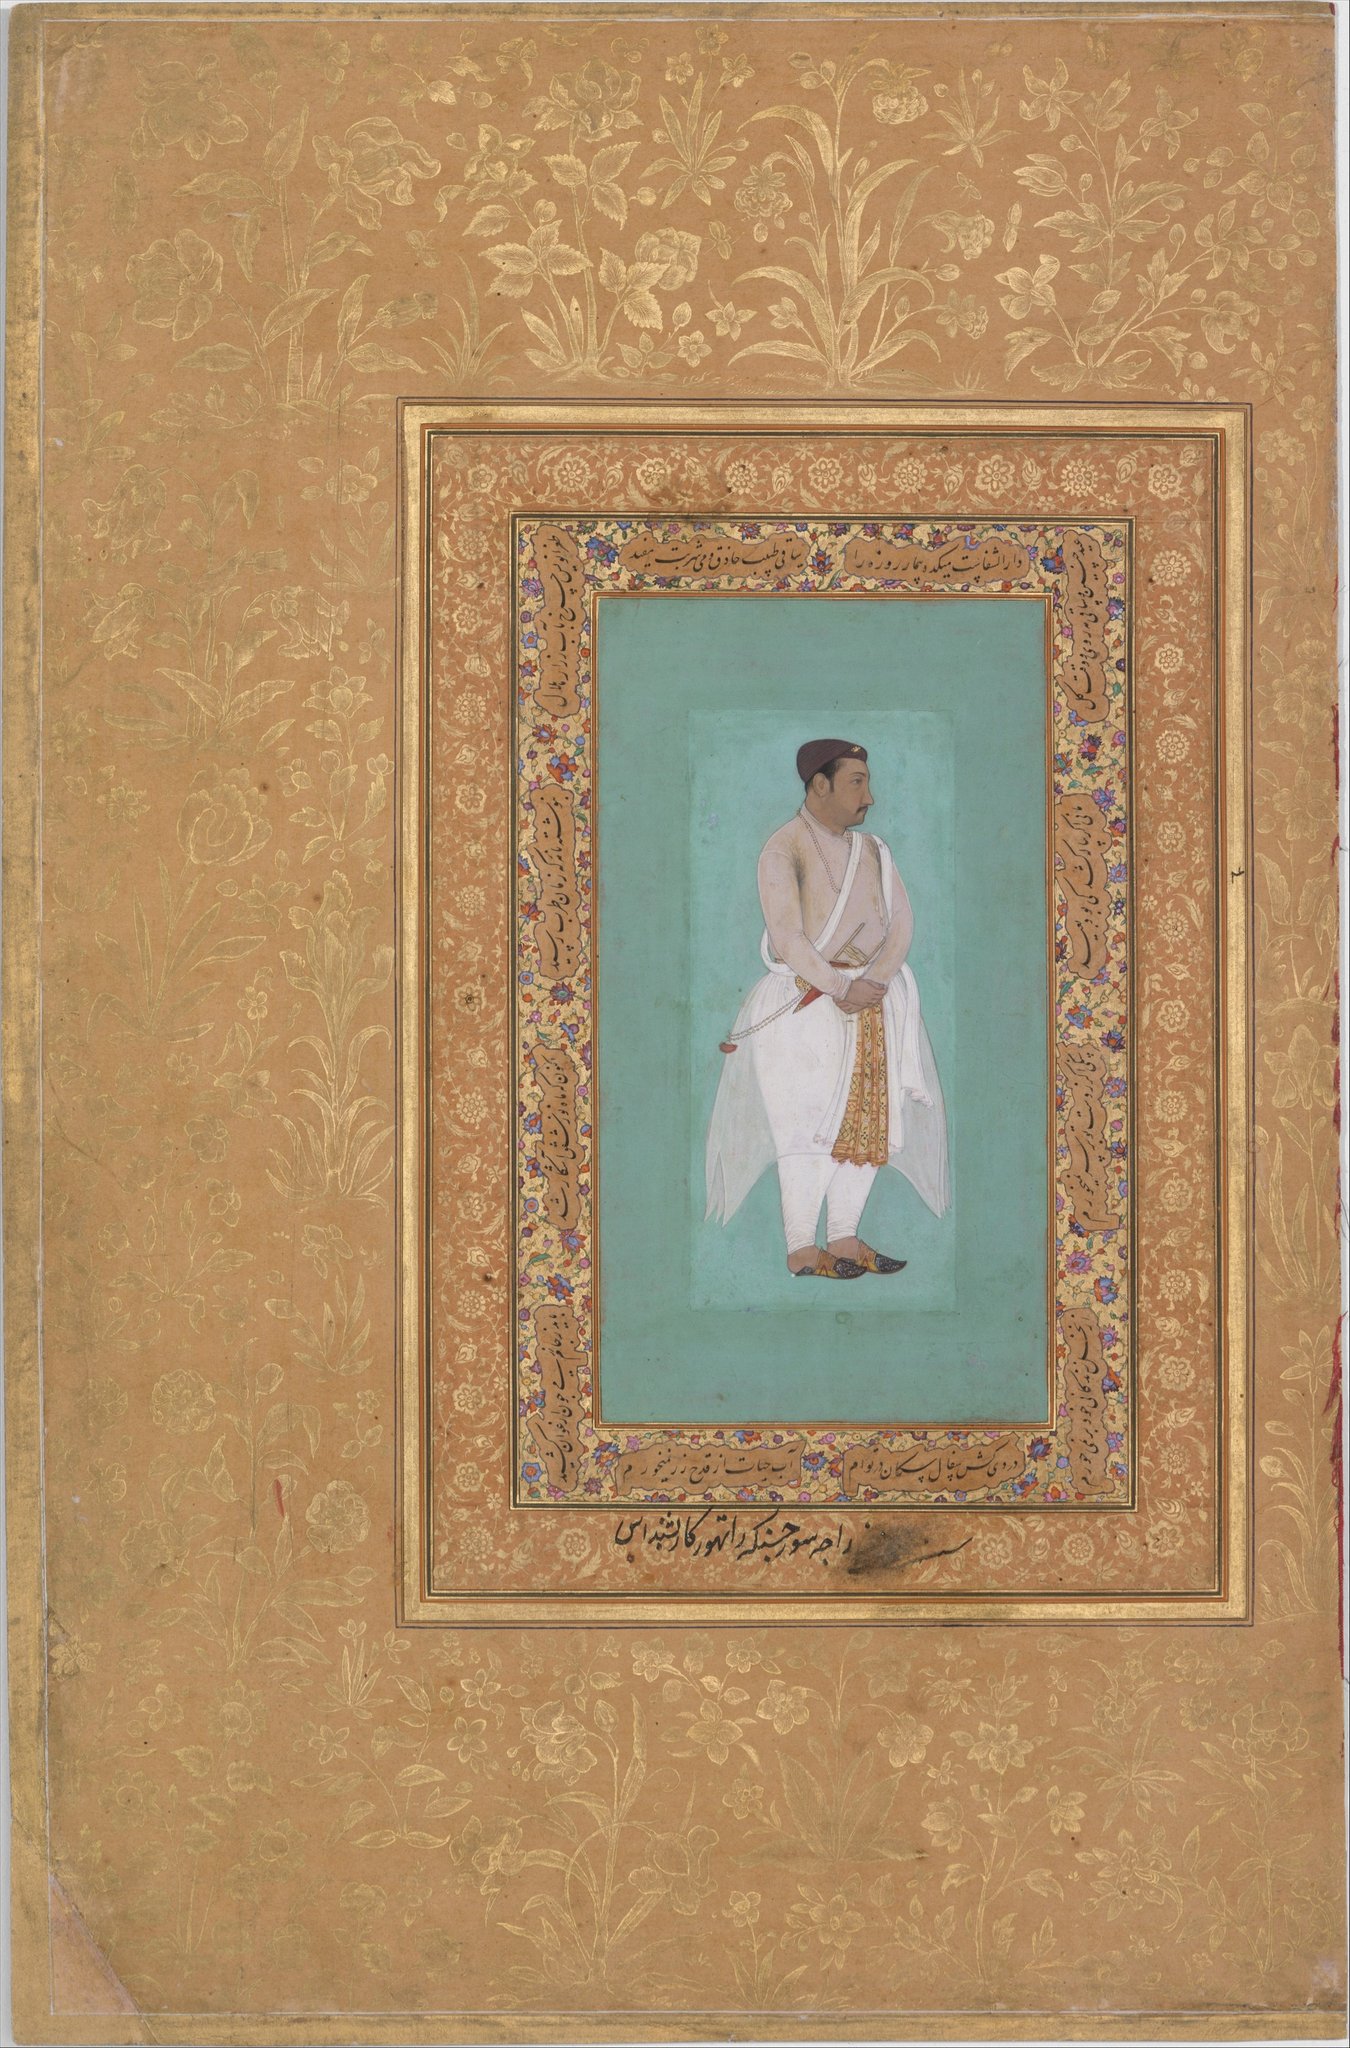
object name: album leaf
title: recto: "Portrait of Raja Suraj Singh Rathor", verso: Page of Calligraphy. Folio from the Shah Jahan Album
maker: bishan das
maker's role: artist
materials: gold, ink, paper, watercolor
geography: india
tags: men,portraits